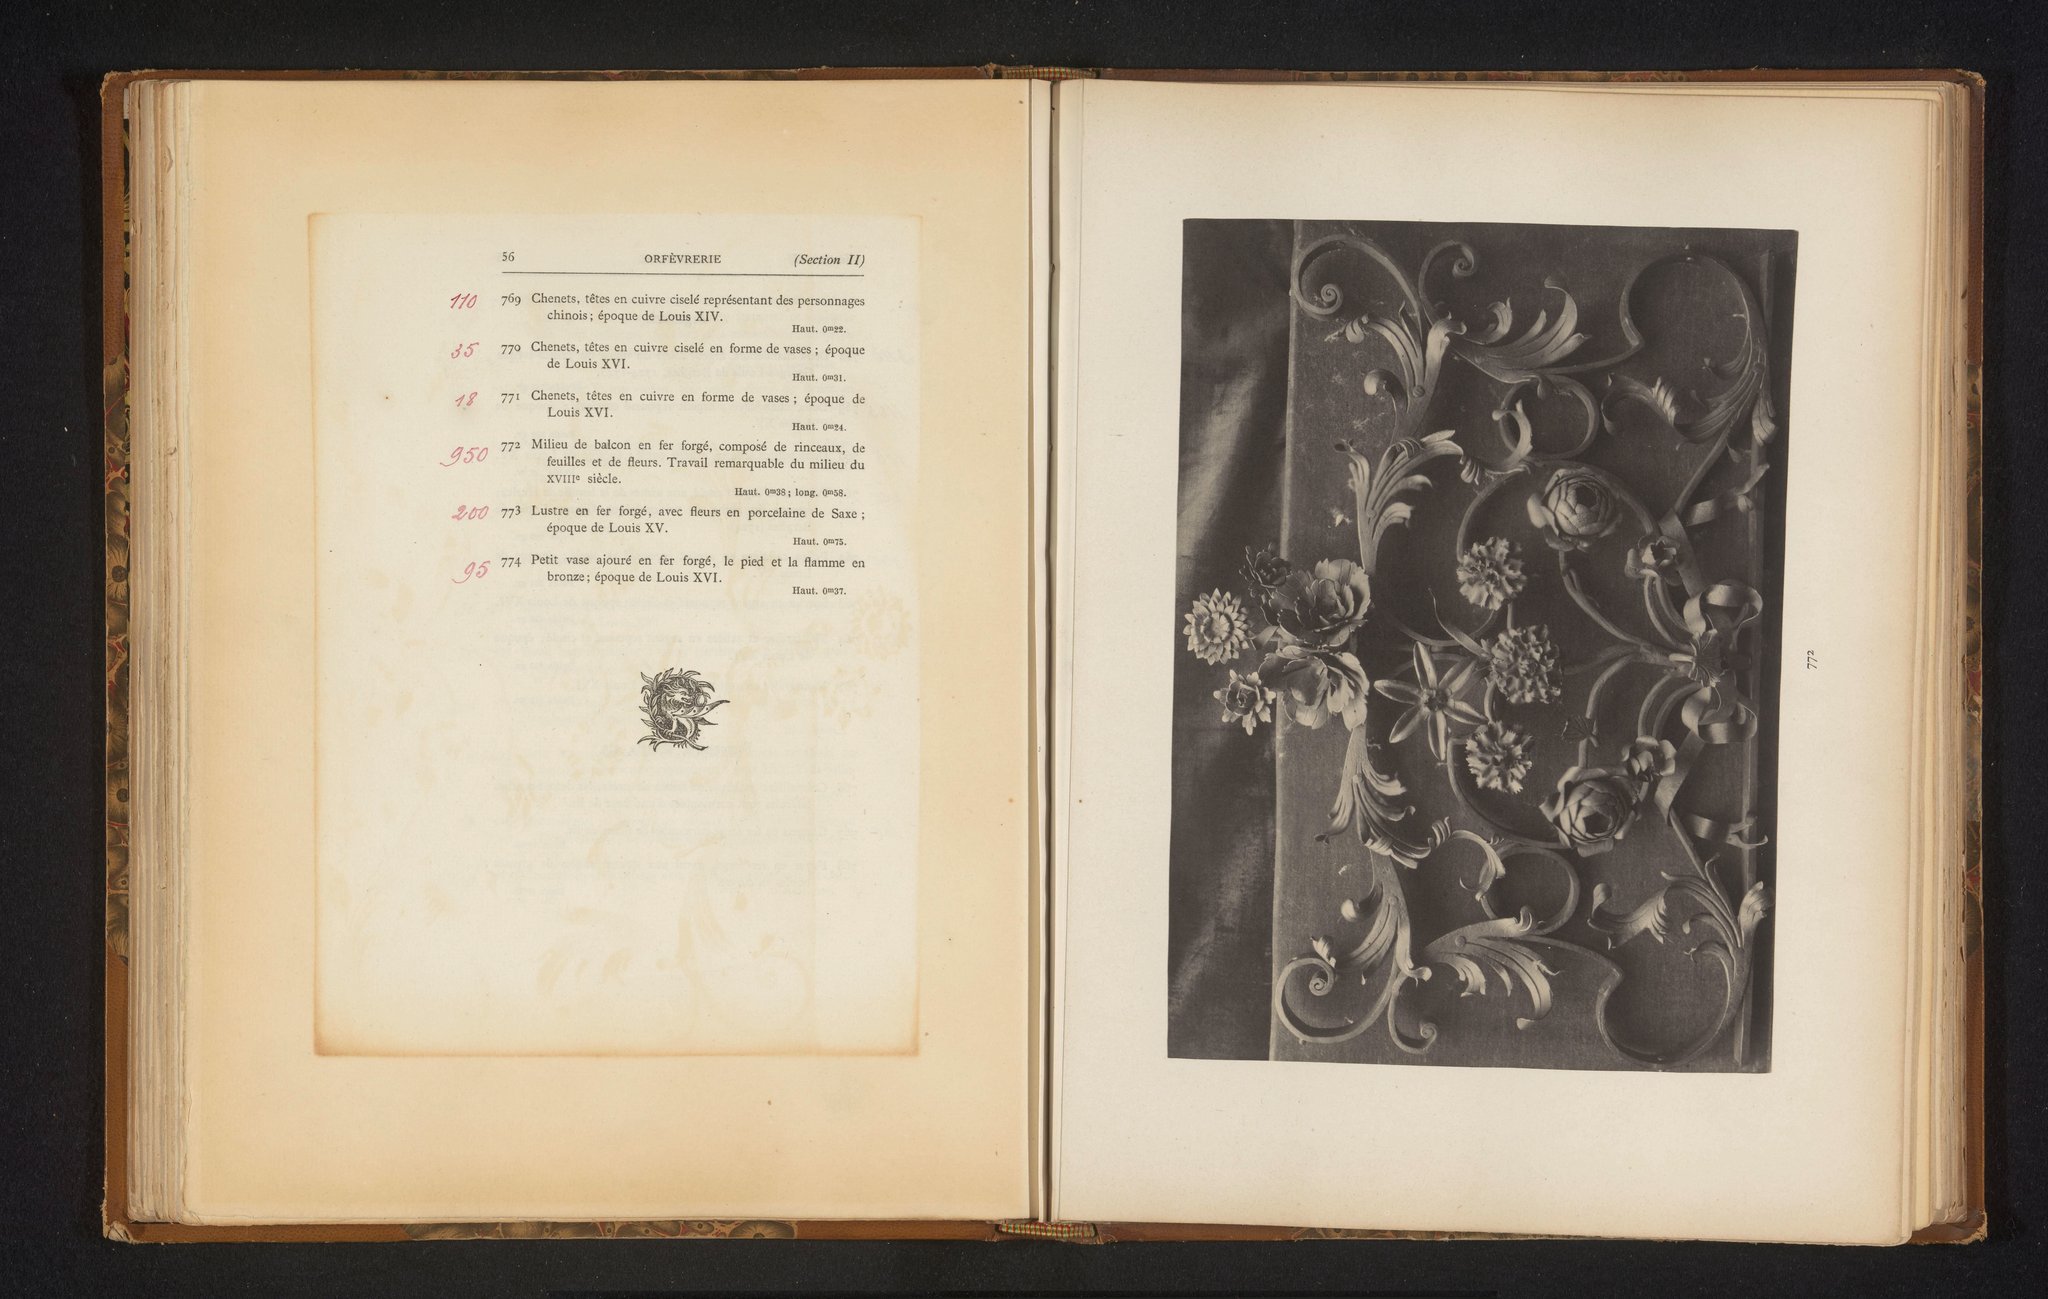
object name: photograph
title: Smeedijzeren werk met bloemen uit de collectie van Antonin Terme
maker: Anonymous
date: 1880-1885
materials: photographic support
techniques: platinum process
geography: liège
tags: art collection, art gallery